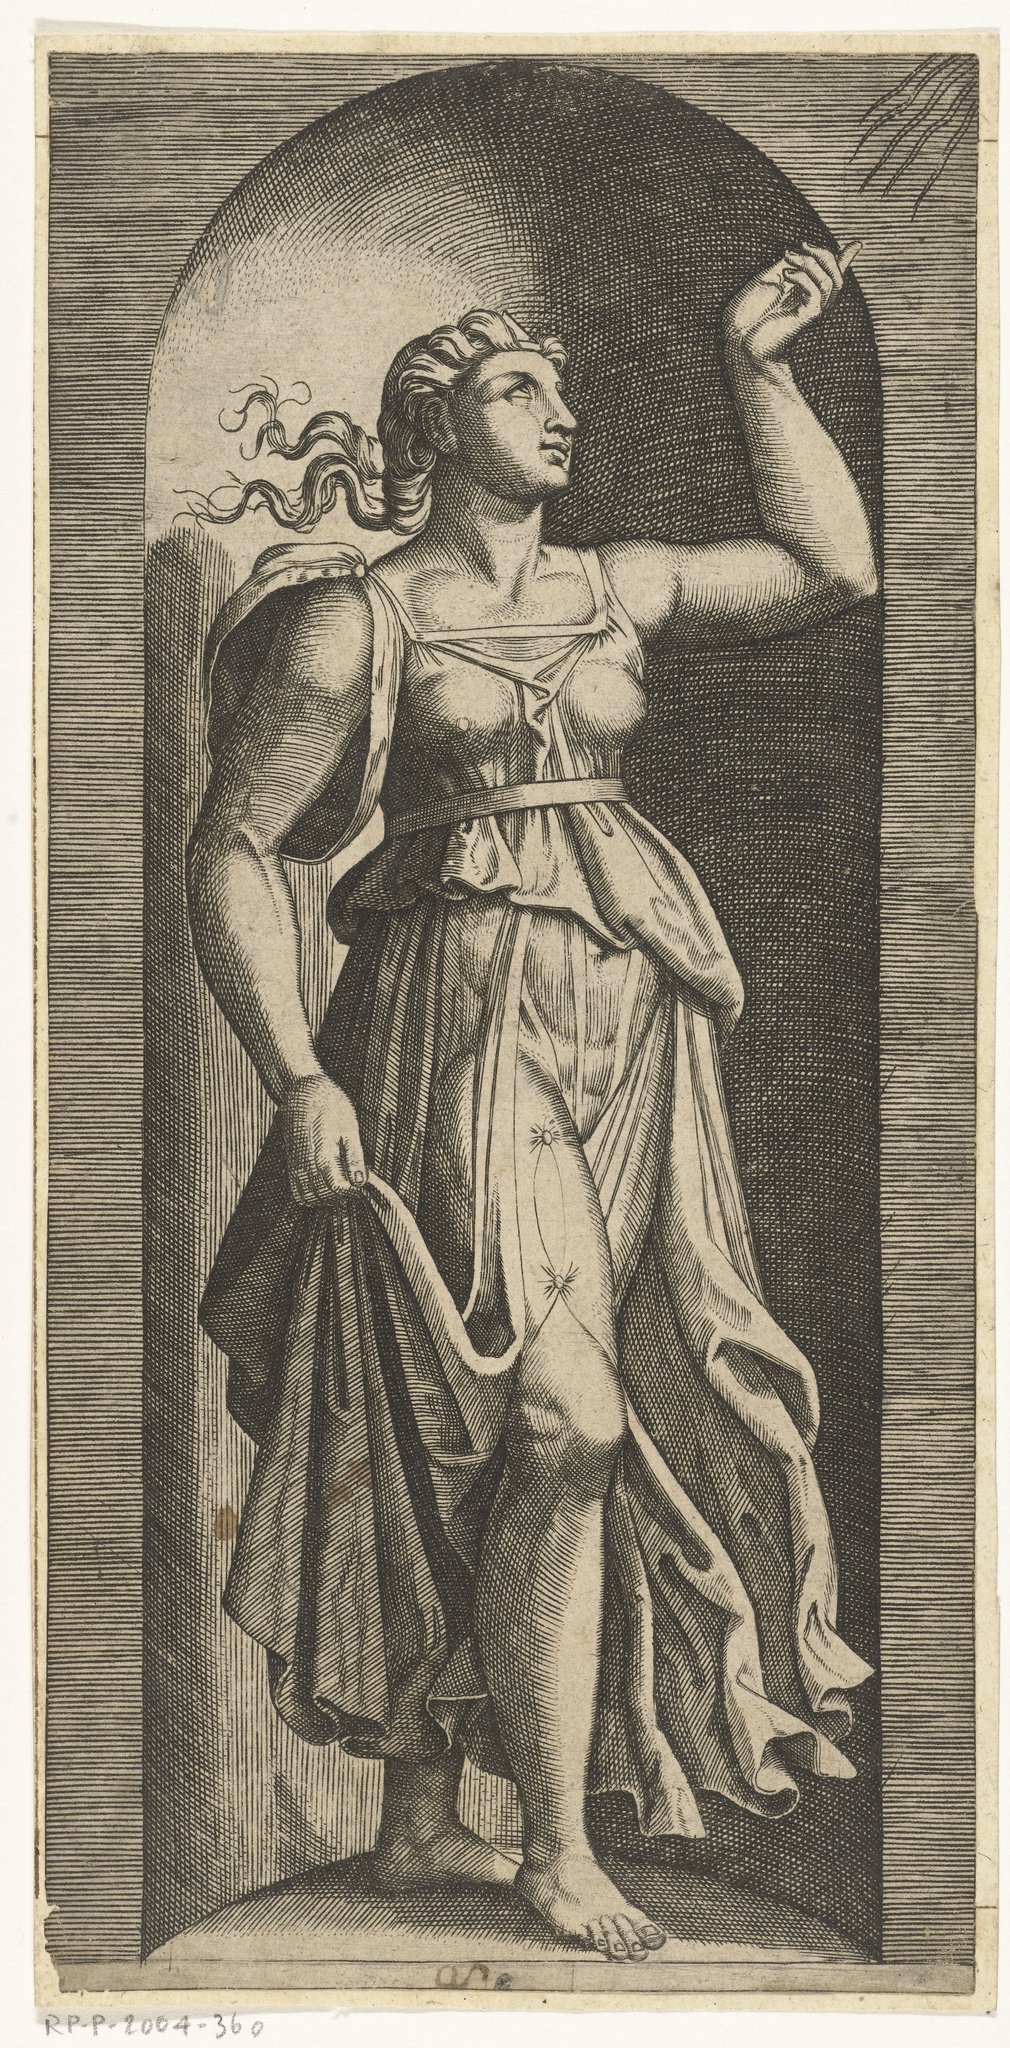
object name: print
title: Vrouw als personificatie van Hoop (Fides) met naar boven opgeslagen ogen staand in nis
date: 1510-1575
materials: paper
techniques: engraving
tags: faith, 'fides'; 'fede', 'fede catholica', 'fede christiana', 'fede christiana catholica' (ripa) ~ one of the three theological virtues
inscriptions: collector's mark: Lugt 2760, collector's mark: Lugt 2228a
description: Kopie in spiegelbeeld naar prent van Marcantonio Raimondi. Raimondi baseerde zich mogelijk op een ontwerp van Raphael. Prent uit een serie van zeven prenten met deugden.